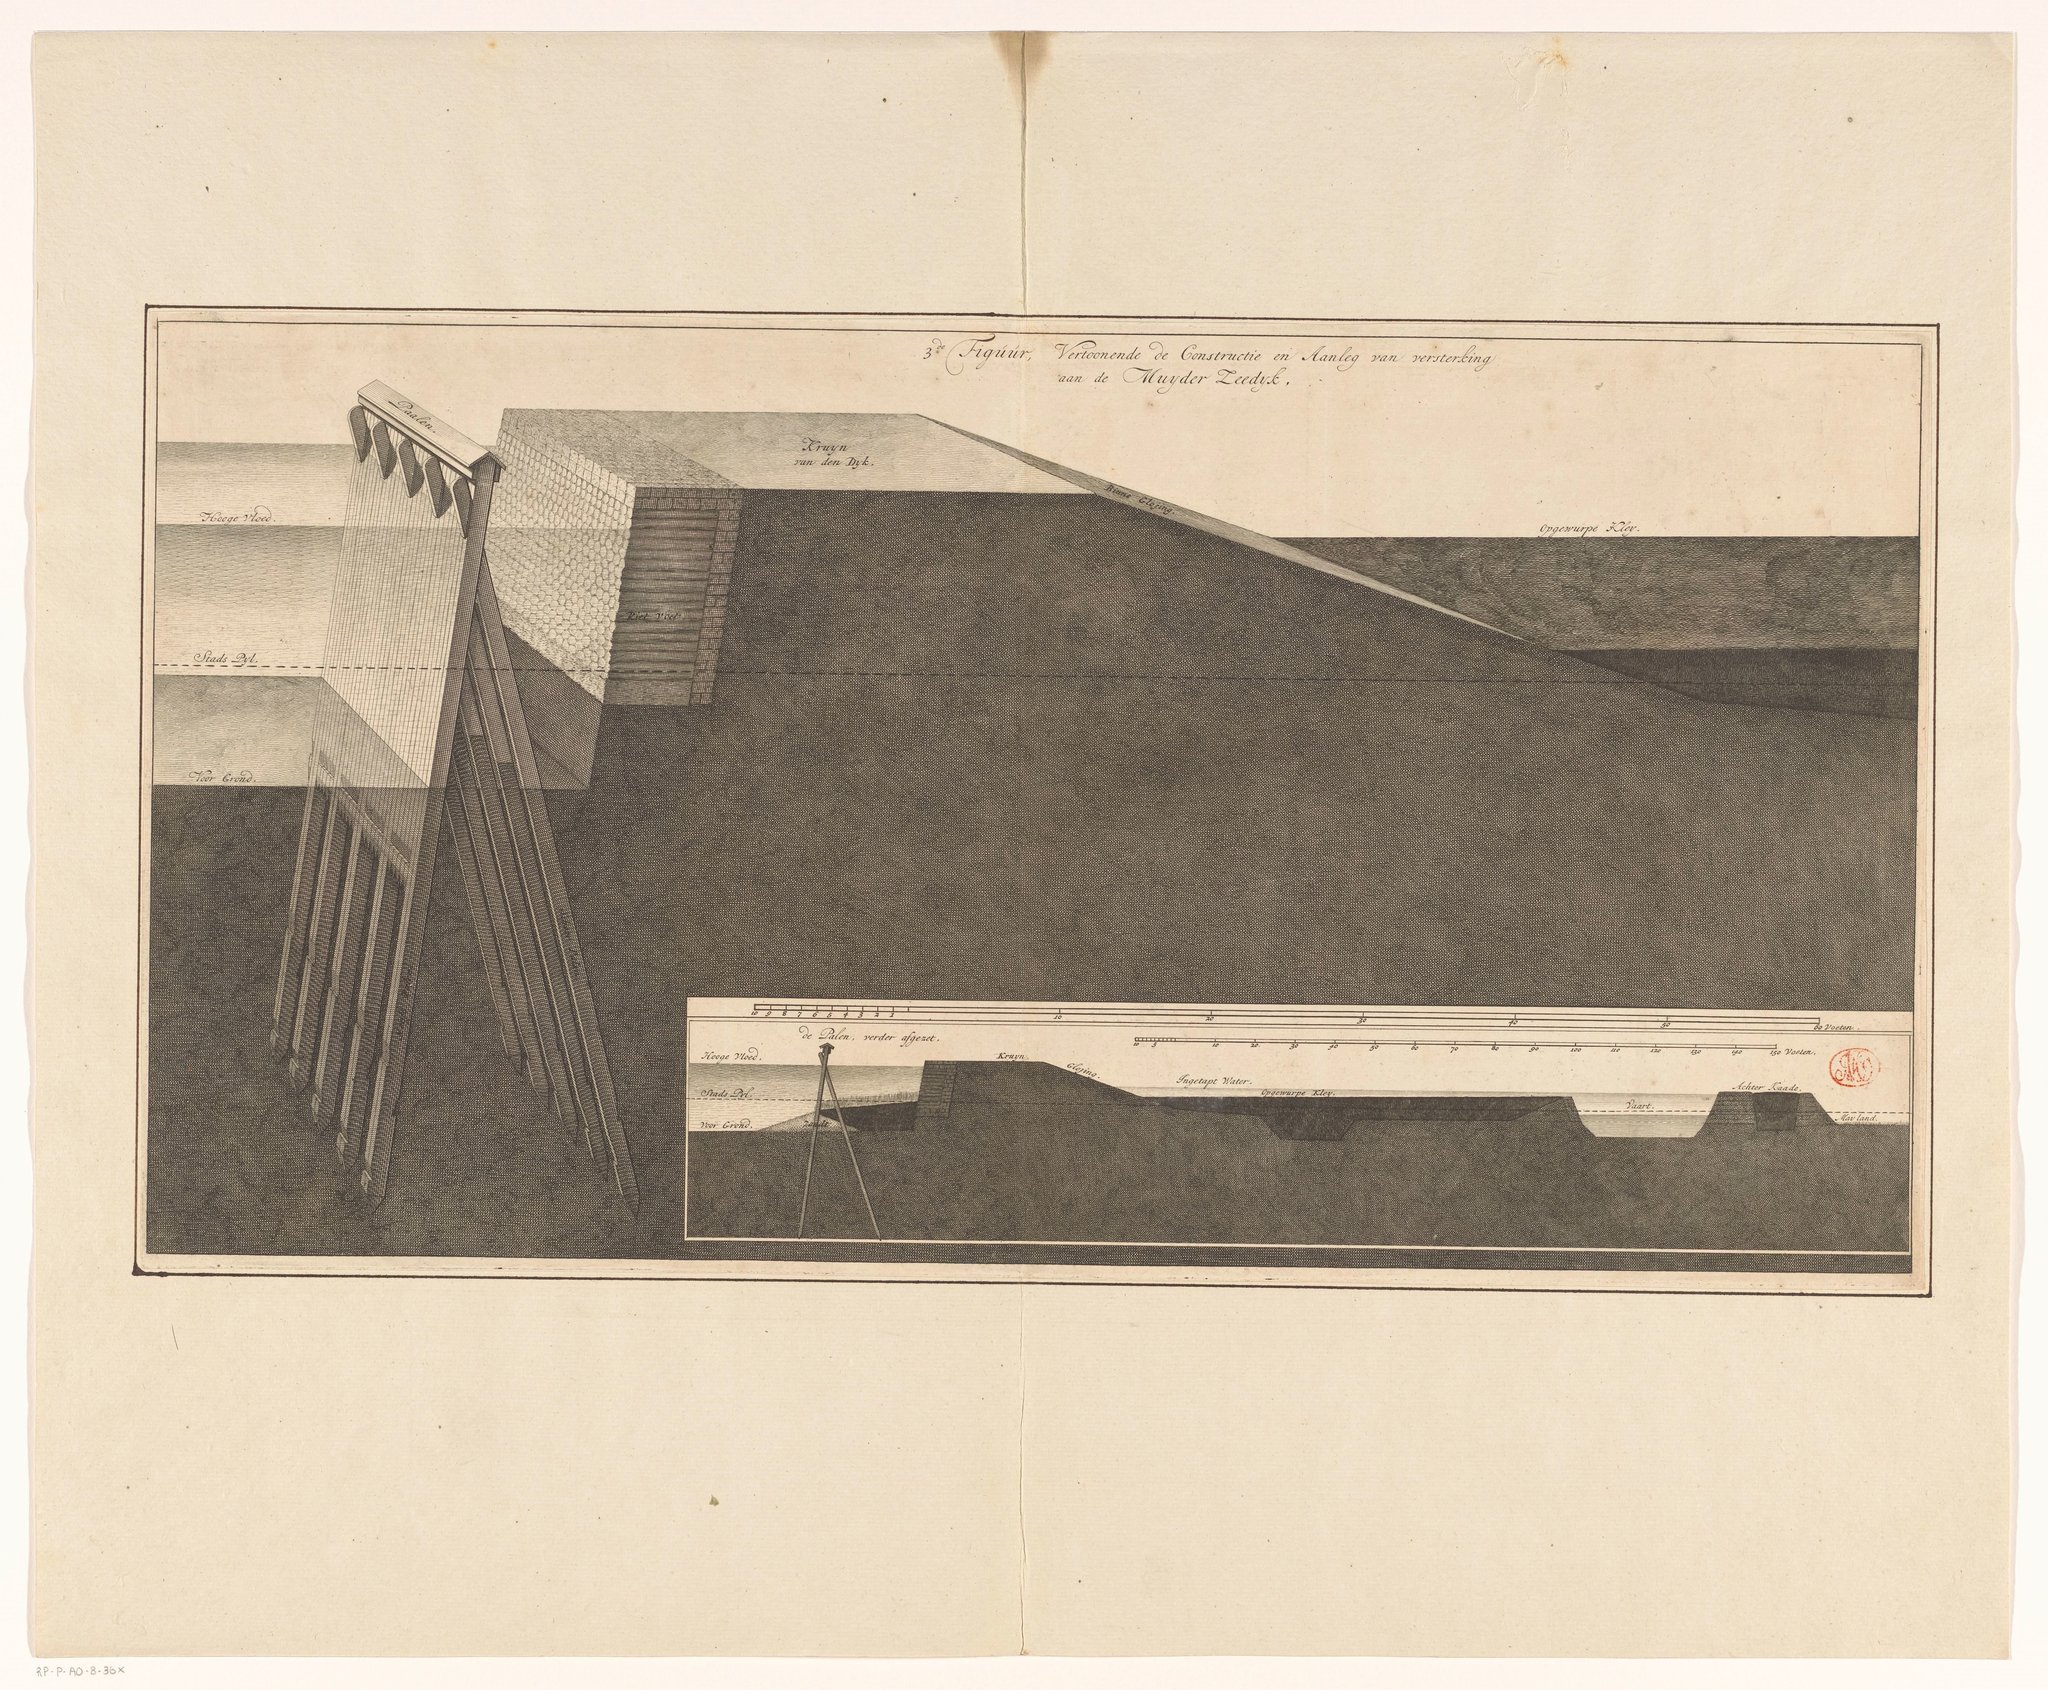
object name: print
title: Twee profielen met een verstevigingsplan voor de zeedijk ten oosten van Muiden, 1703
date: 1703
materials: paper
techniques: engraving, etching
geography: amsterdam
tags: dikes, levee, amsterdam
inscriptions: collector's mark: Lugt 195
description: Prent gebruikt in: Heyden, Jan van der (de Jonge). Berigt nopende den toestand van de zeedyk, tussen Amsterdam en Muyden, volgens ordre van de edele groot achtbare heeren burgemeesteren en regeerders der stad Amsterdam, (…). Amsterdam: s.n., s.a. [1703]. Zie RP-P-AO-8-35, RP-P-AO-8-36 en RP-P-AO-8-37 voor andere prenten uit deze publicatie. Zie RP-P-AO-8-35A en RP-P-AO-8-37B voor prenten over de later uitgevoerde verstevigingen van de dijk.